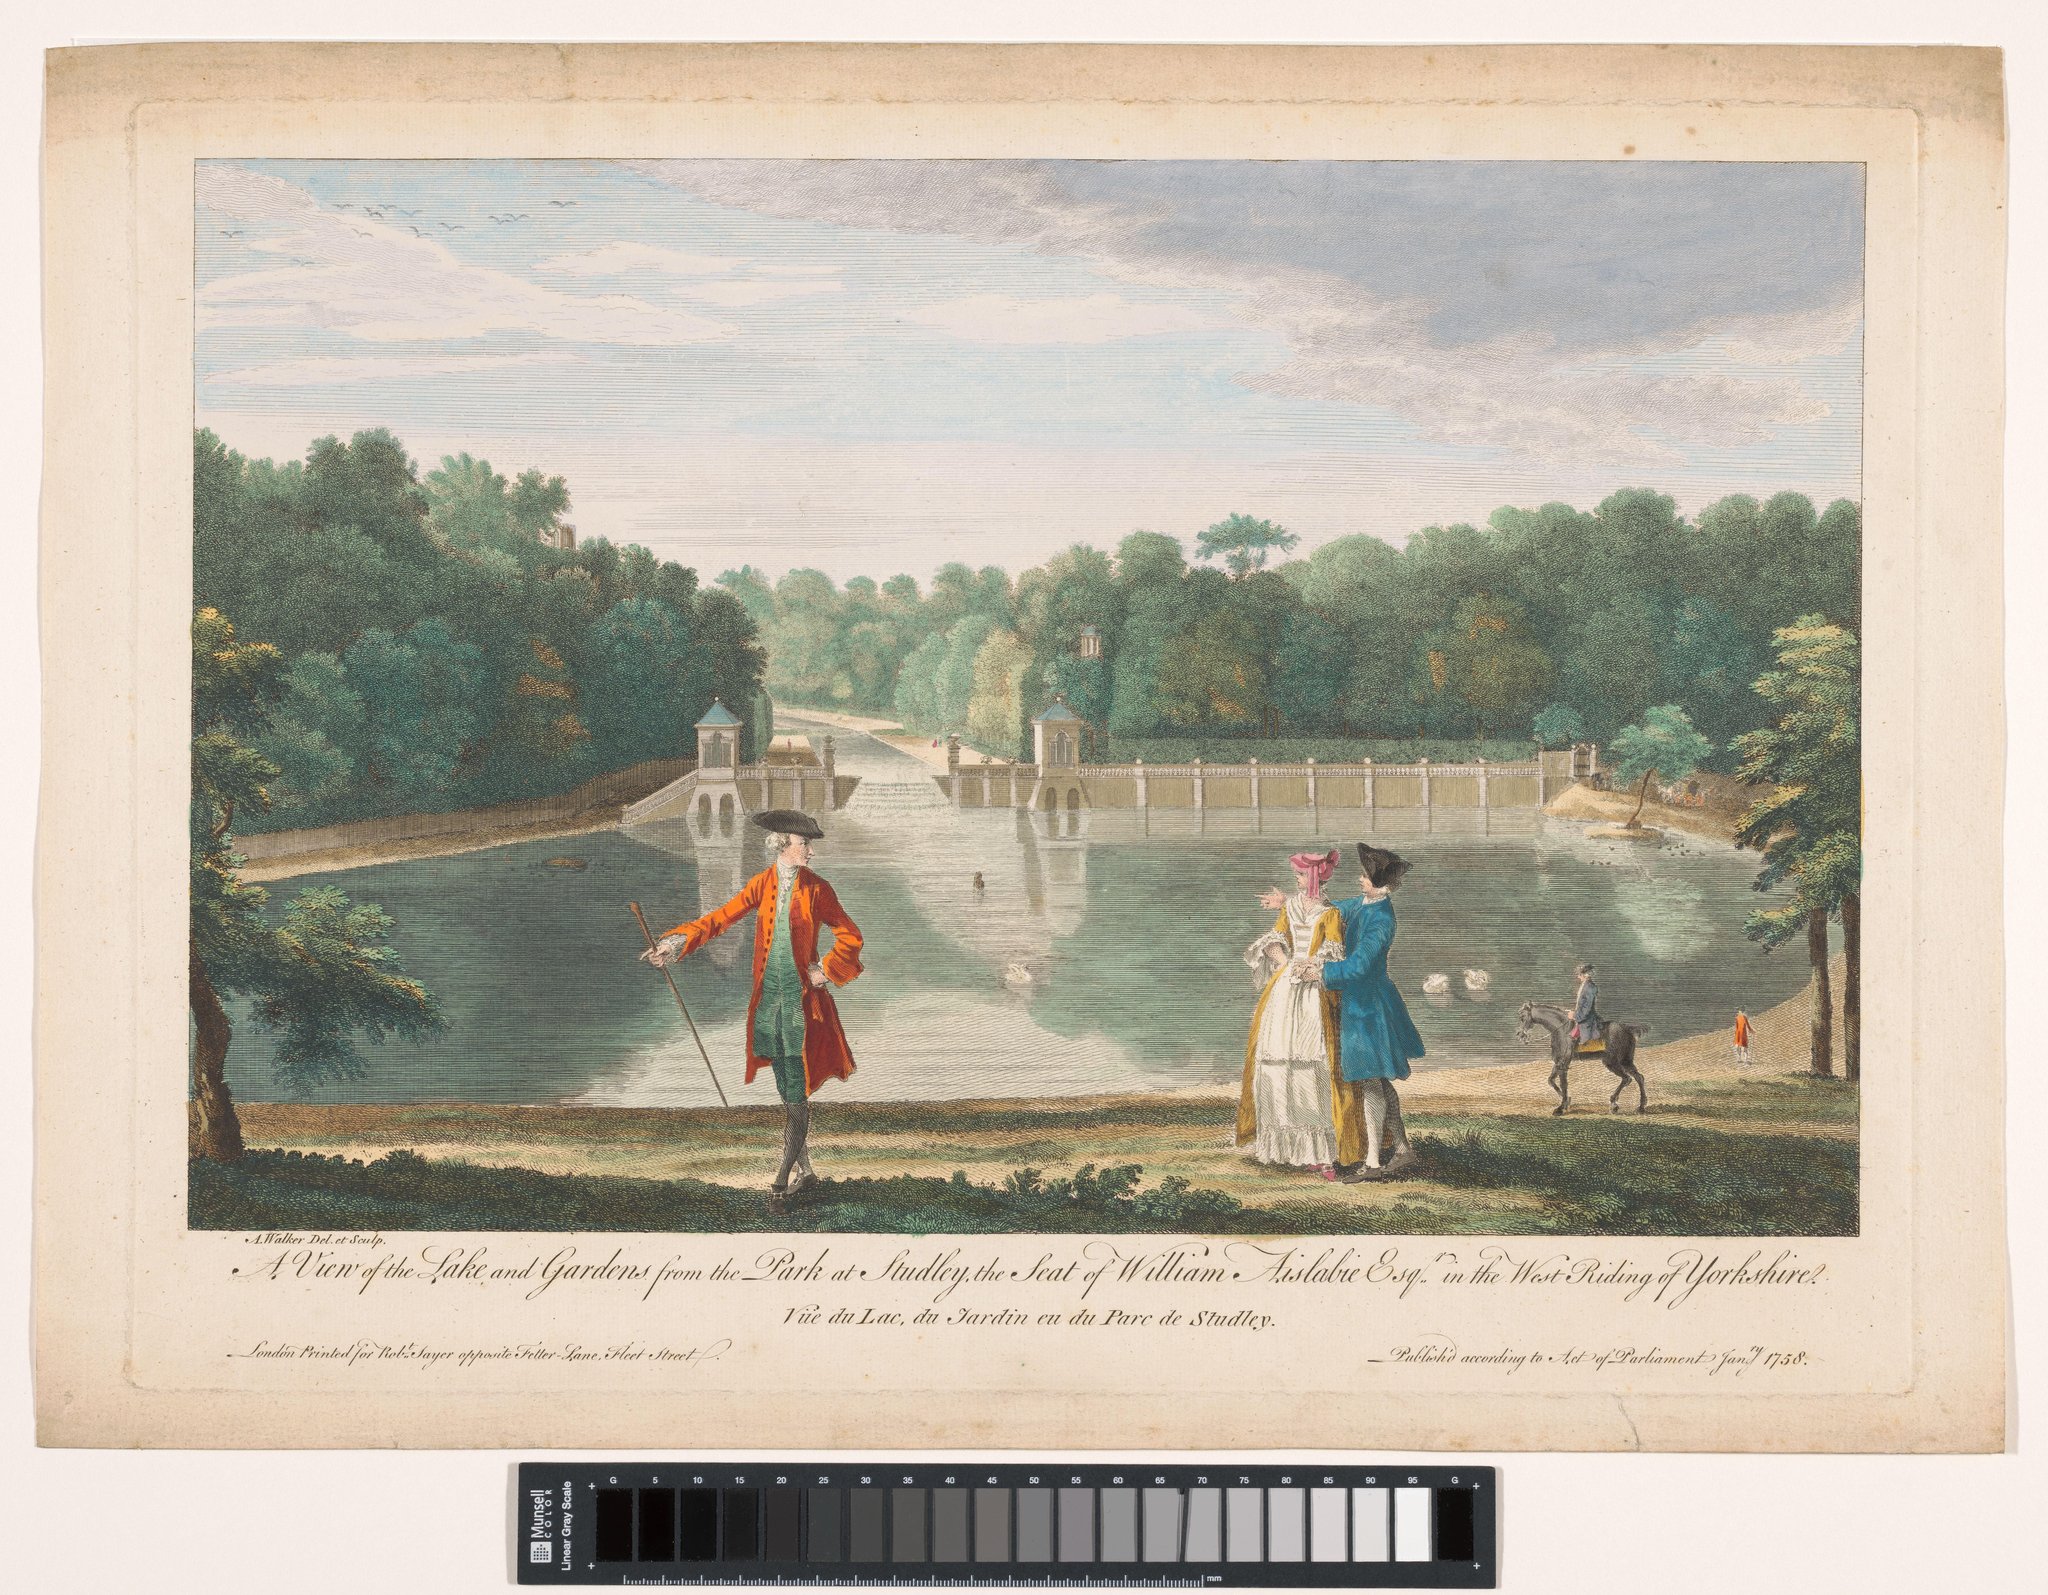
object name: print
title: Gezicht op een meer in Studley Royal Park te Yorkshire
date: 1701-1758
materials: paper, watercolor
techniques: brush, etching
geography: england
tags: garden, water-works in garden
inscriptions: date